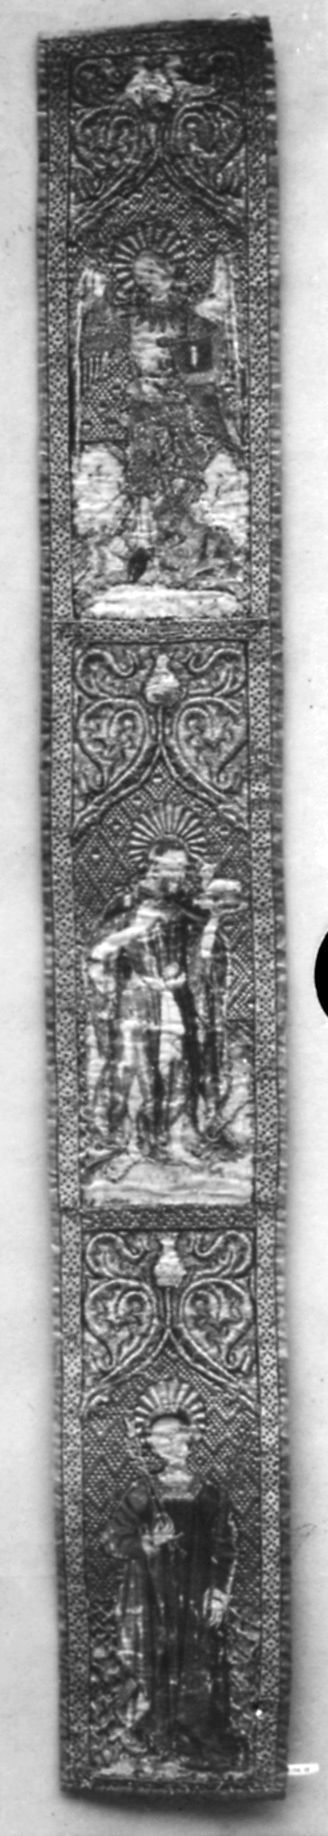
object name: orphrey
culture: spanish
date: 1401-1500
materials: gold thread, silk